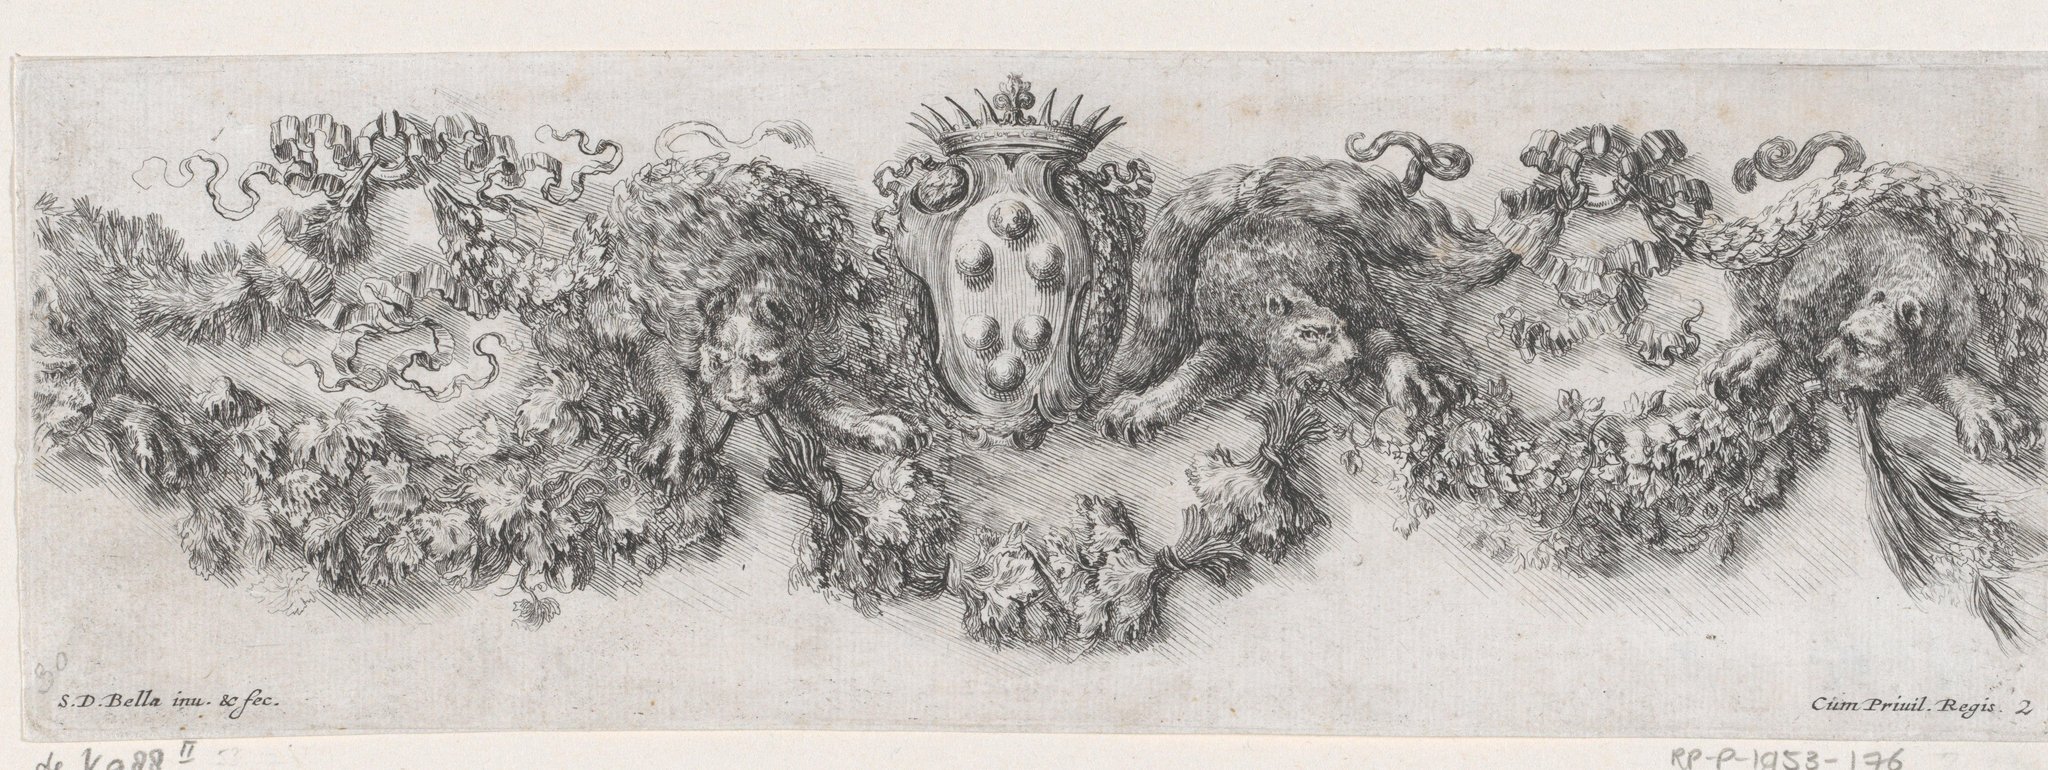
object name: ornament print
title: Ornamentele friezen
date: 1620-1664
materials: paper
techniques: etching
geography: paris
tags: coat of arms (symbol of sovereignty), beasts of prey, predatory animals: panther, foliage, tendrils, branches ~ ornament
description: Een fries met het wapen van de familie De' Medici met aan weerszijden twee panters met guirlandes van bladeren in hun bek.